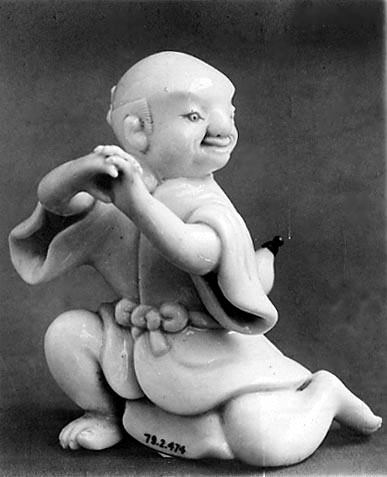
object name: ornament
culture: japanese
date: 1701-1800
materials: glaze, porcelain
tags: men